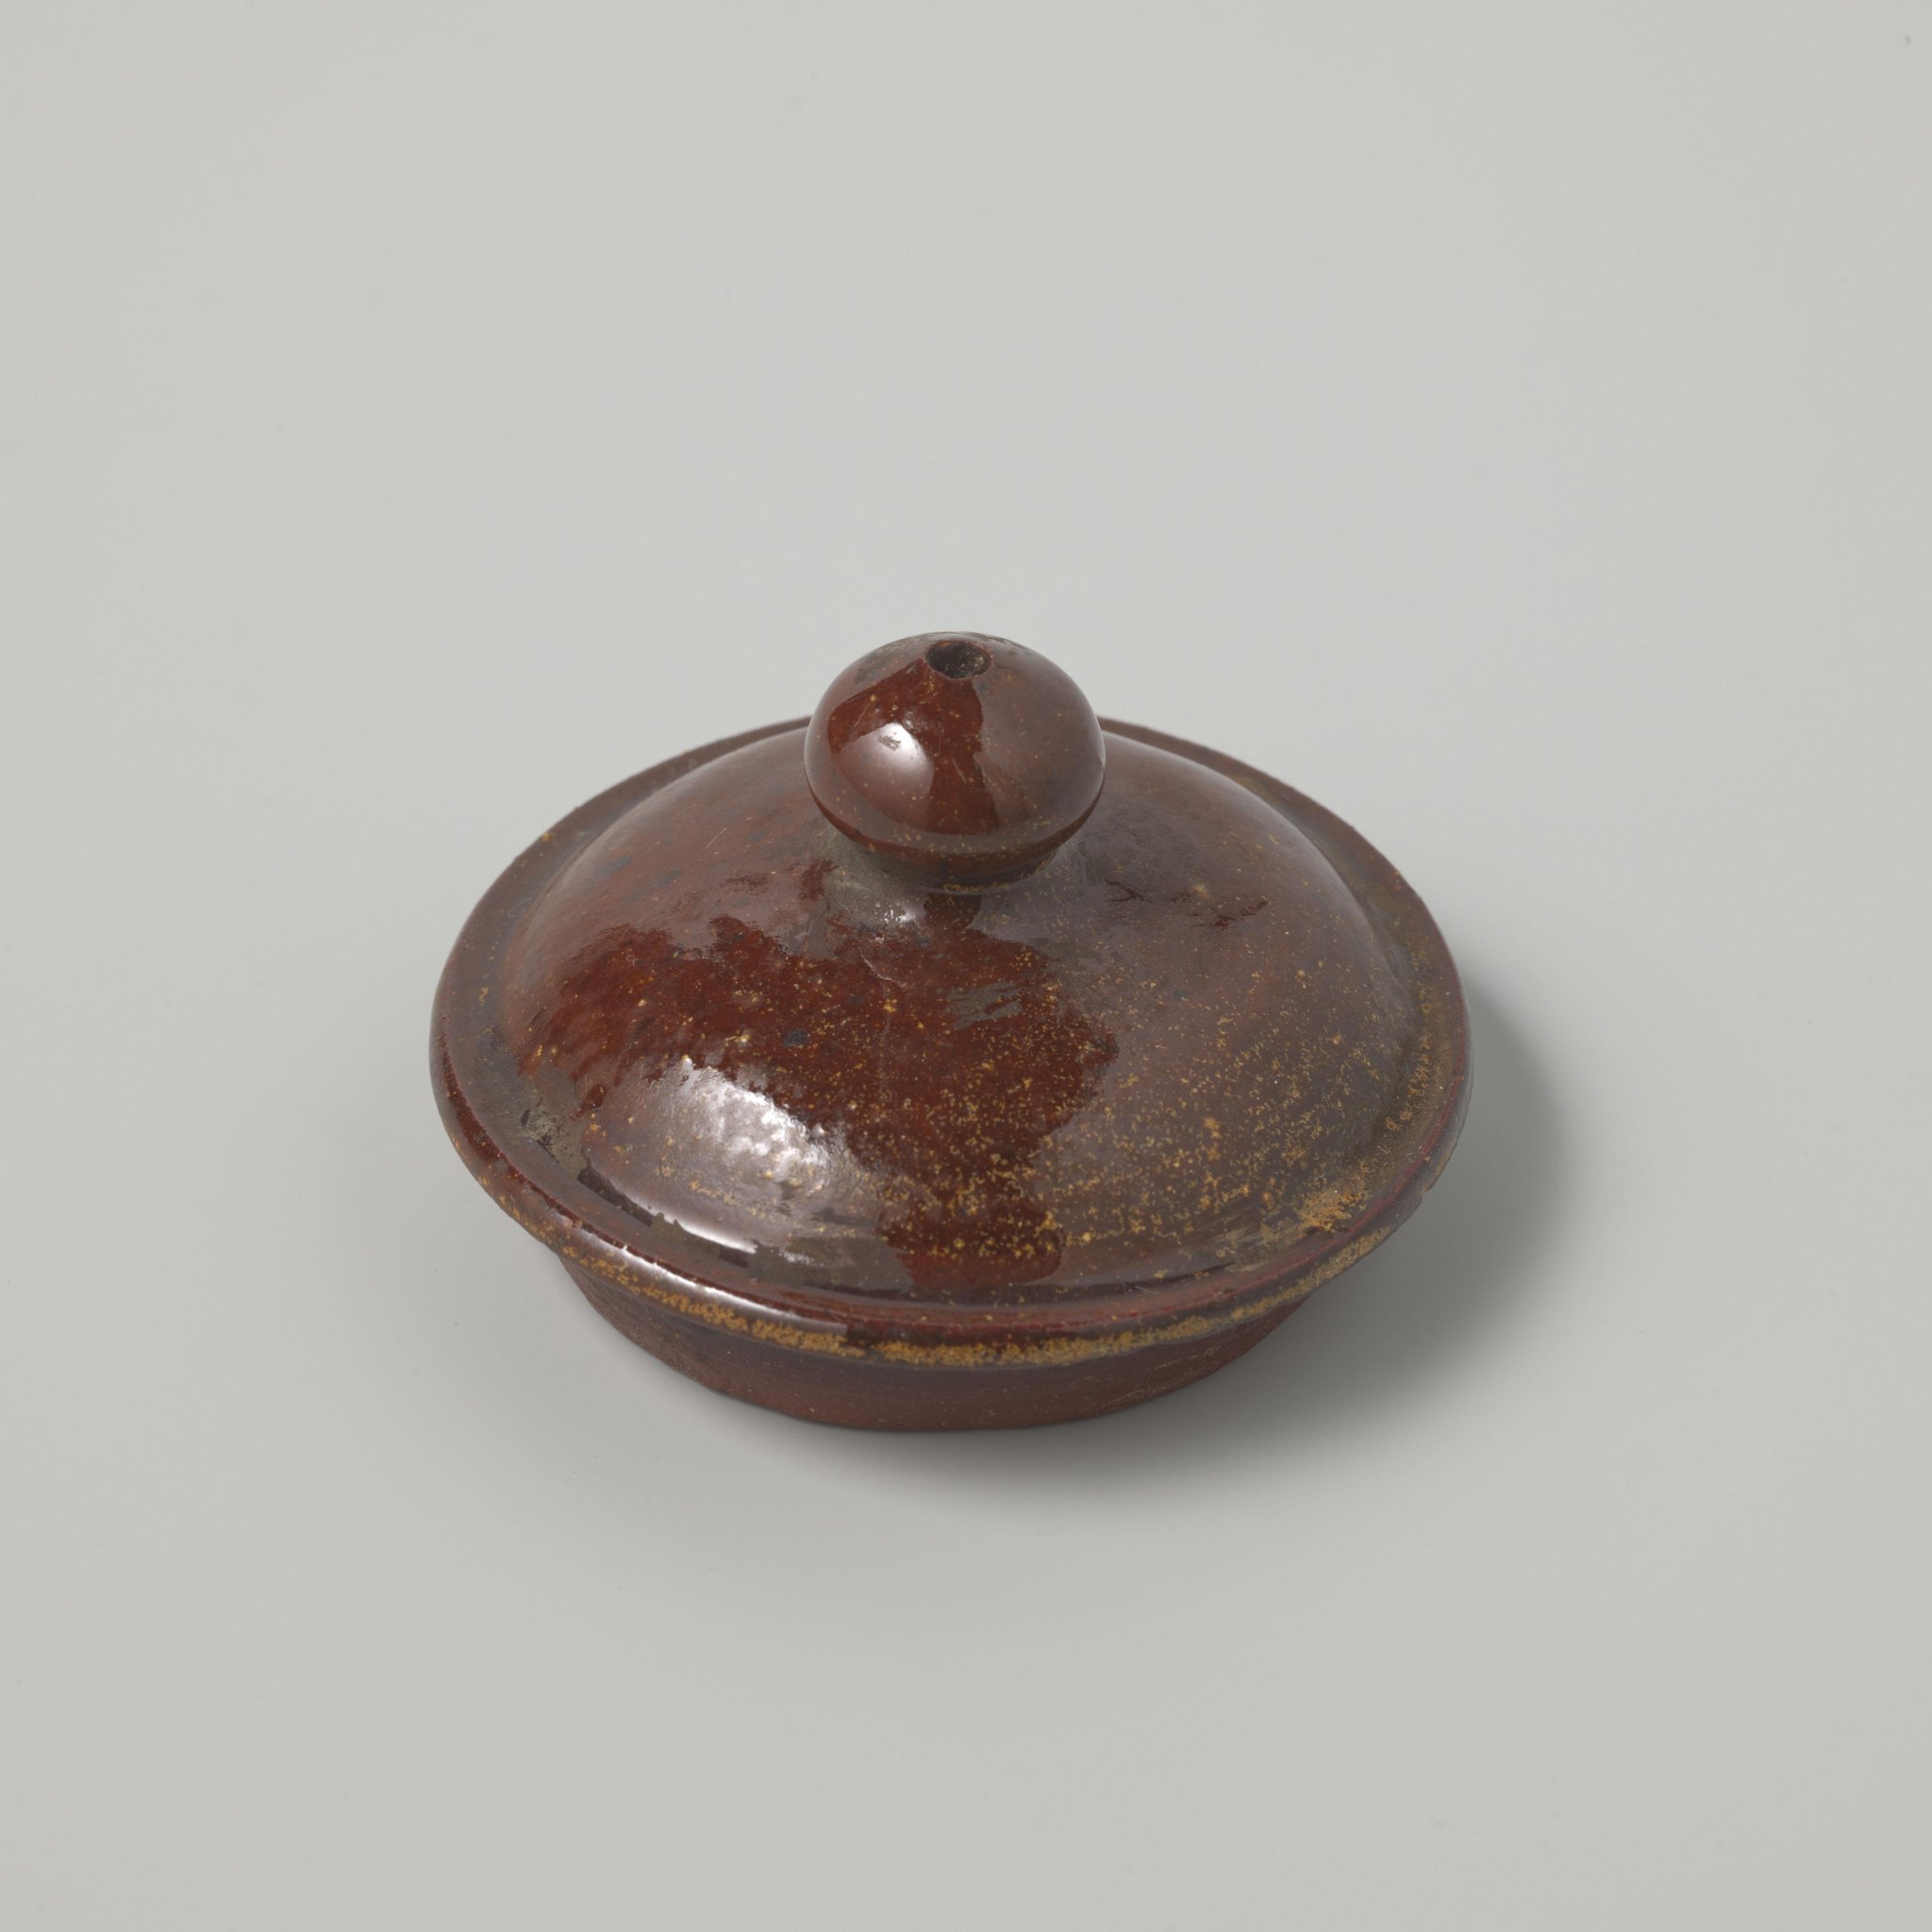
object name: lid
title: Deksel van een theepot met een bruin glazuur (De Caluwe bakafval)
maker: jacobus de caluwe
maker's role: plateelbakkerij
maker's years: -1730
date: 1700-1725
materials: earthenware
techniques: firing, vitrification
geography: delft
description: Toegeschreven aan Jacobus de Caluwe, omdat dit voorwerp samen met gemerkte stukken (‘Jacobus De Caluwe’ en rennend hert) gevonden is op de plaats waar zich De Caluwes tweede werkplaats bevond. Er is een duidelijke stilistische overeenkomst tussen de gemerkte en niet gemerkte voorwerpen uit deze archeologische vondst.